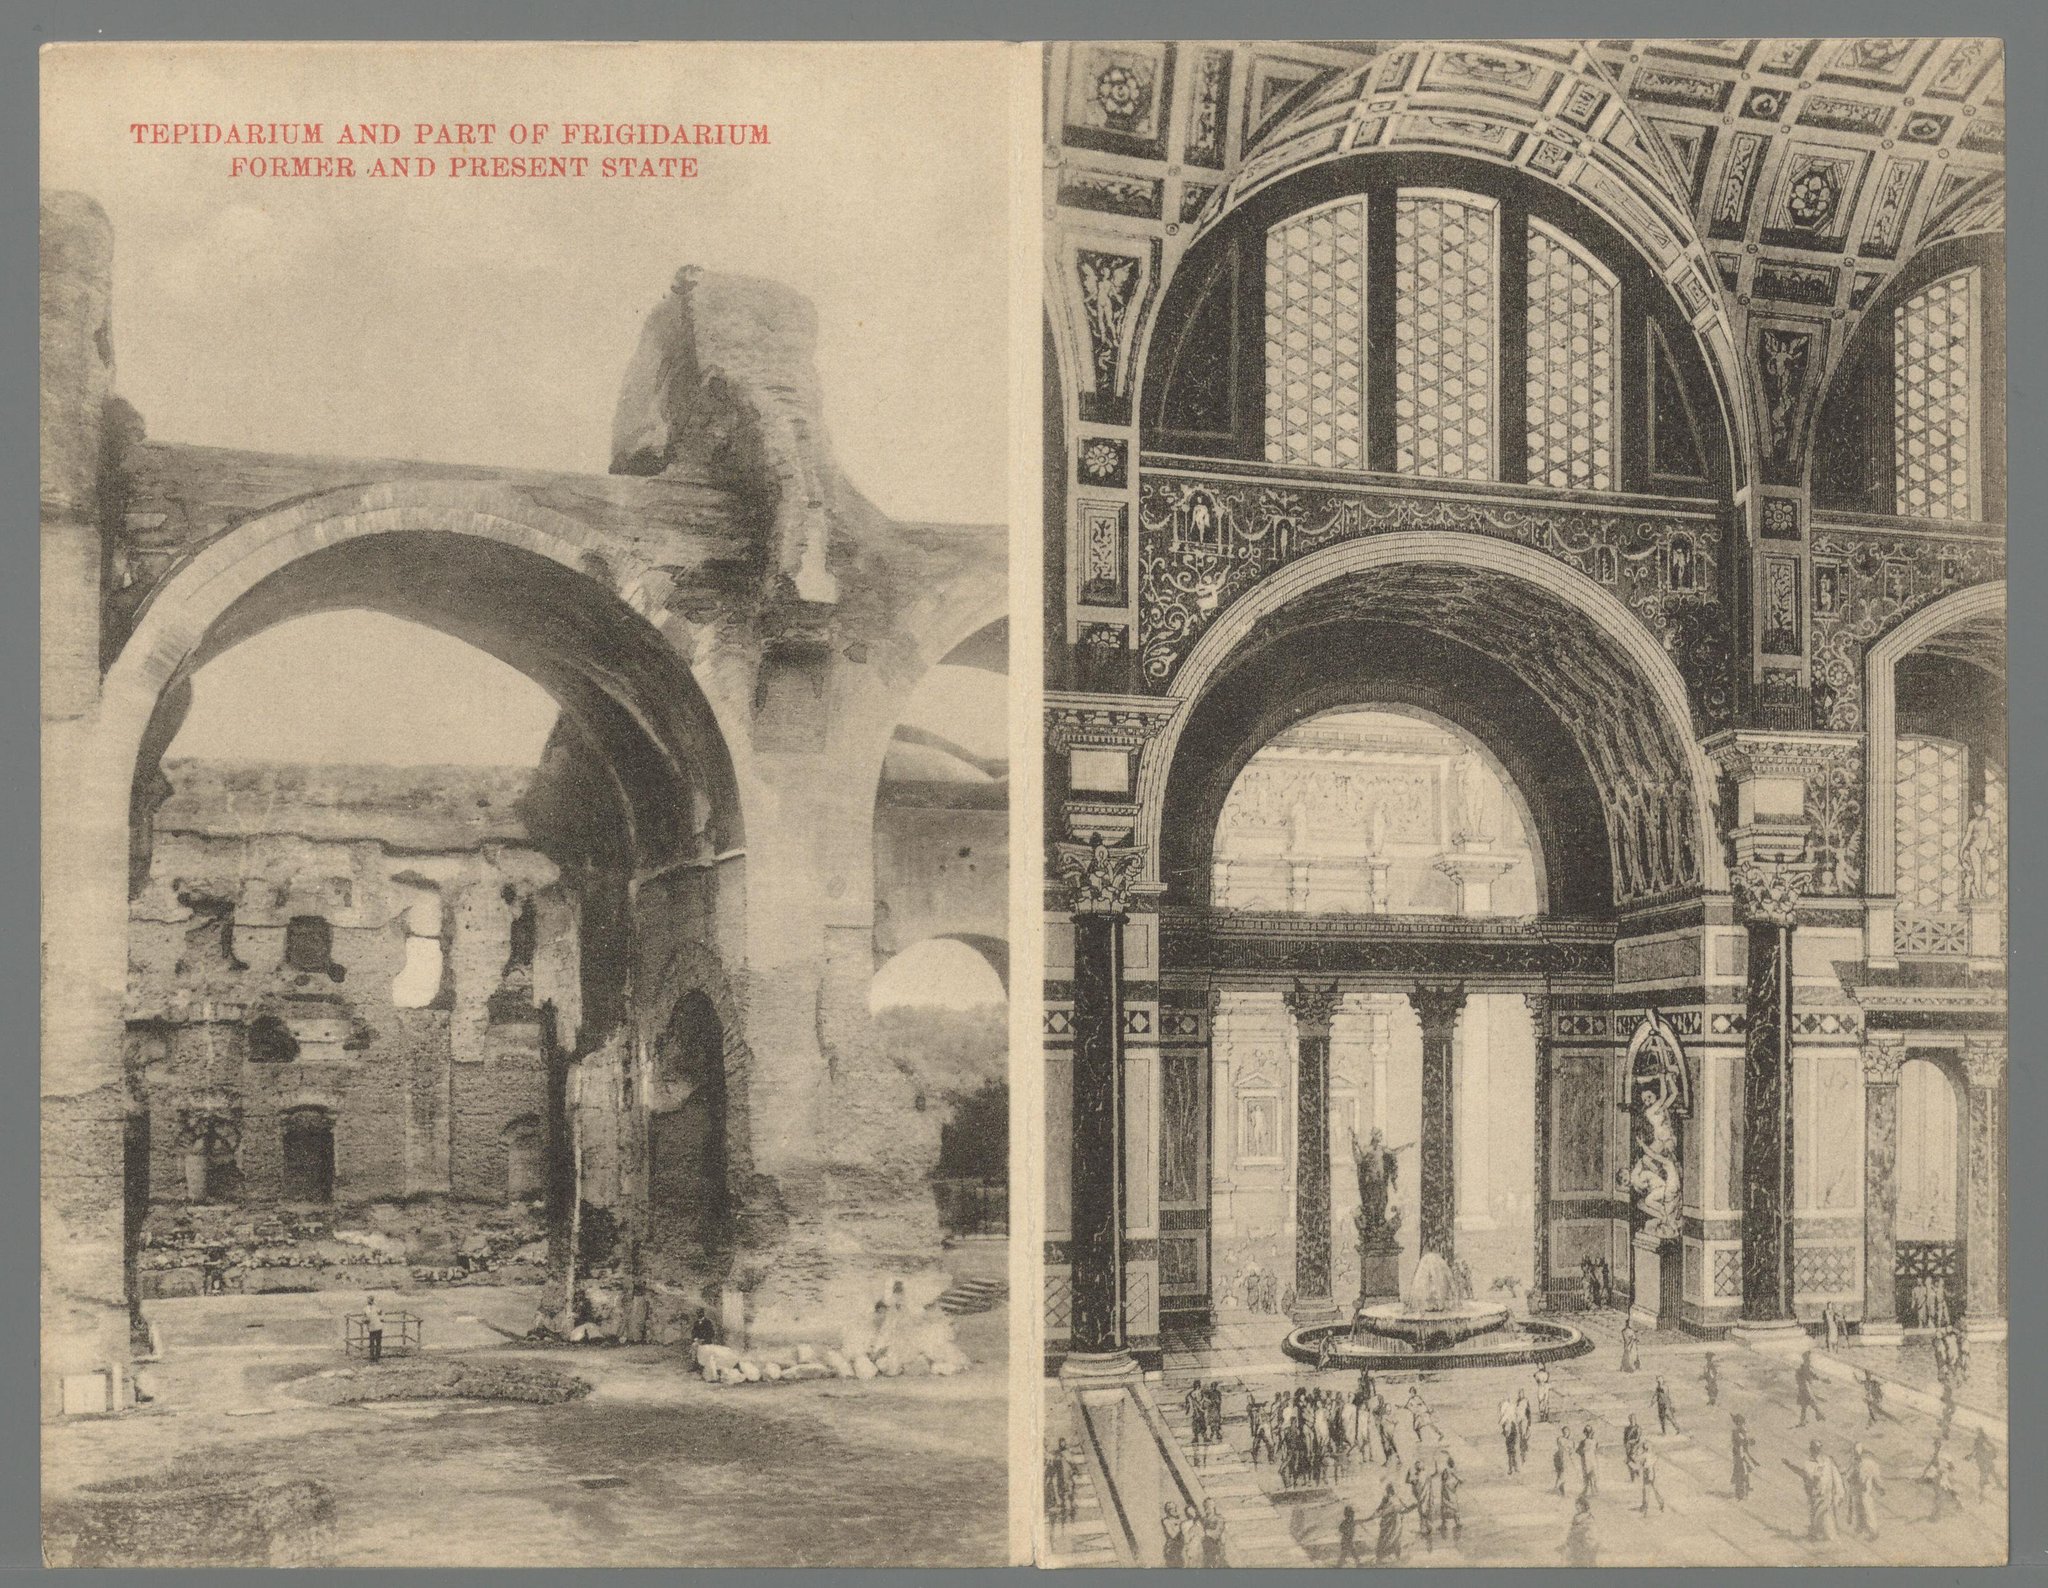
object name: photomechanical print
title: Tepidarium and Part of Frigidarium. Former and Present State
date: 1906-1930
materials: cardboard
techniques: photograph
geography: rome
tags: ruin of a building ~ architecture, public baths (+ many persons)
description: Twee voorstellingen op één uit te klappen kaart: vroeger en nu. Links de restanten van de ruïnes van de Thermen van Caracalla. Rechts een voorstelling van het intacte bouwwerk in de Romeinse tijd.